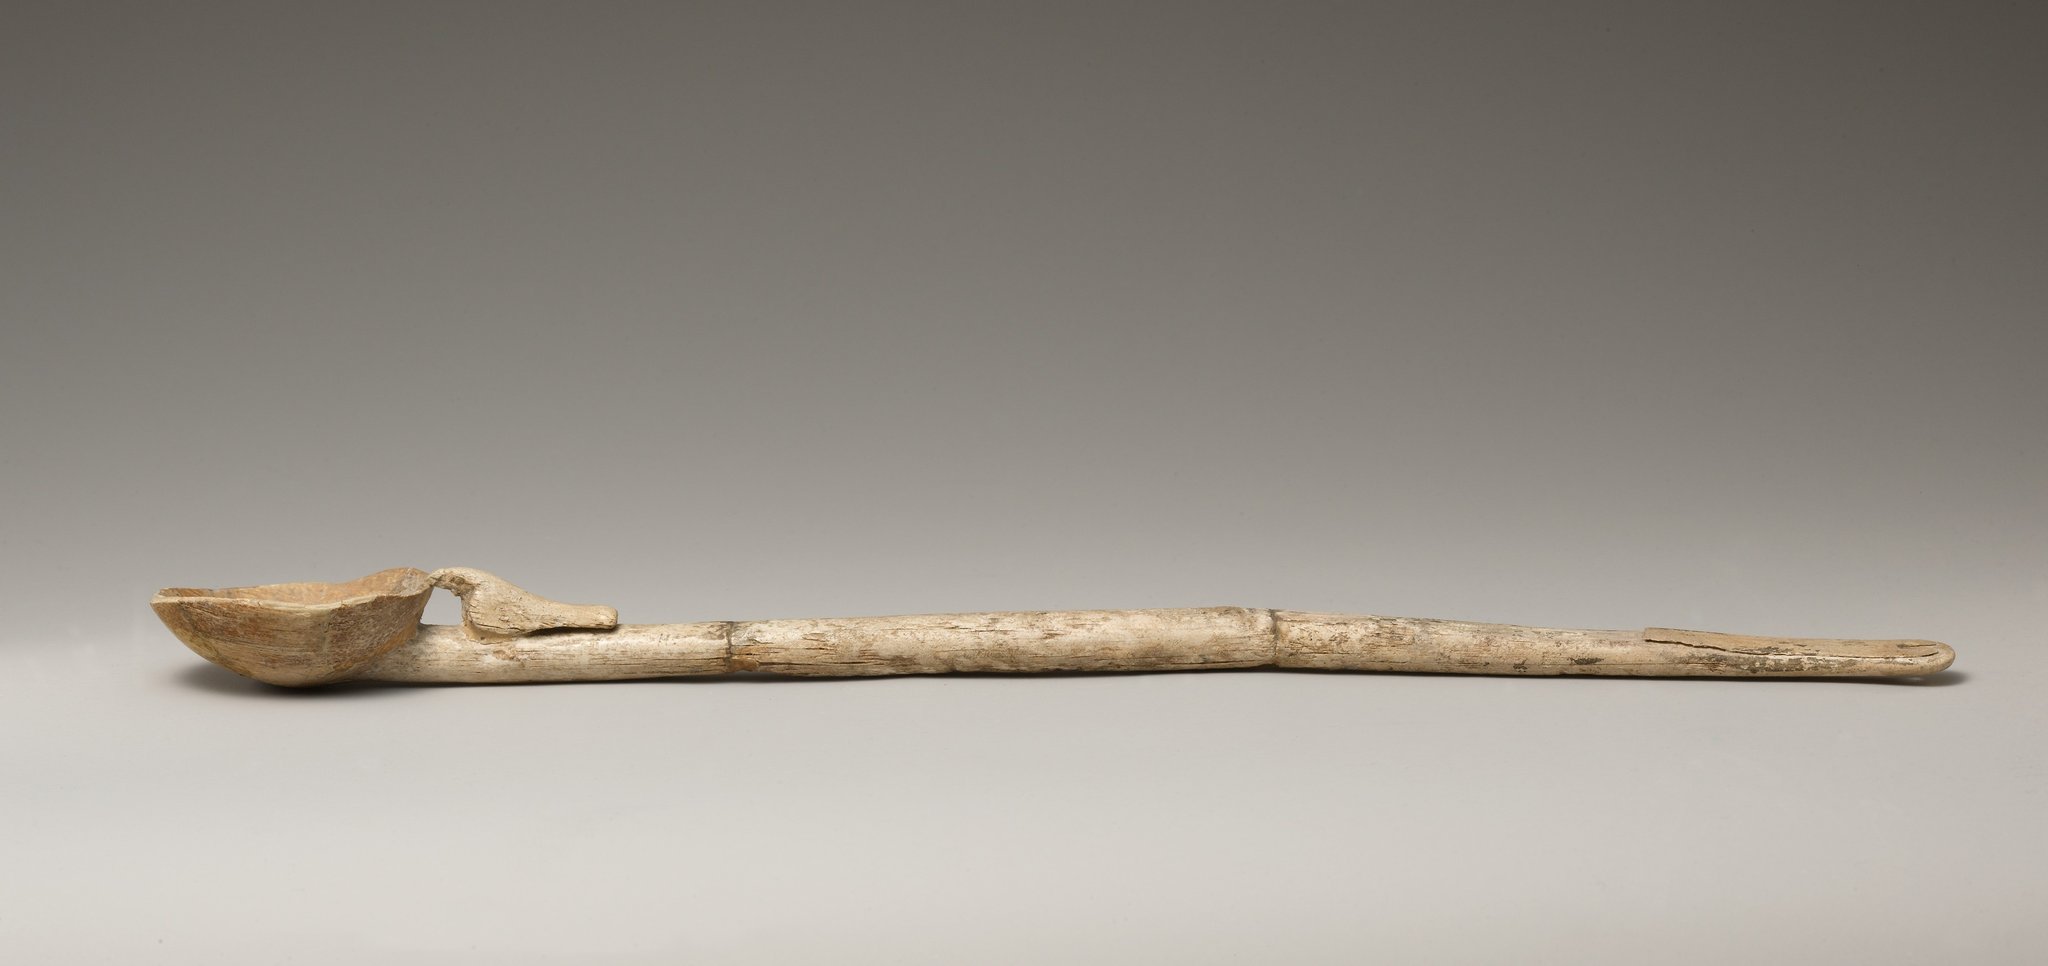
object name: spoon, bird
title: Spoon with a falcon on the handle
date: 3300-3100 BCE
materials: ivory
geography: egypt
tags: falcons